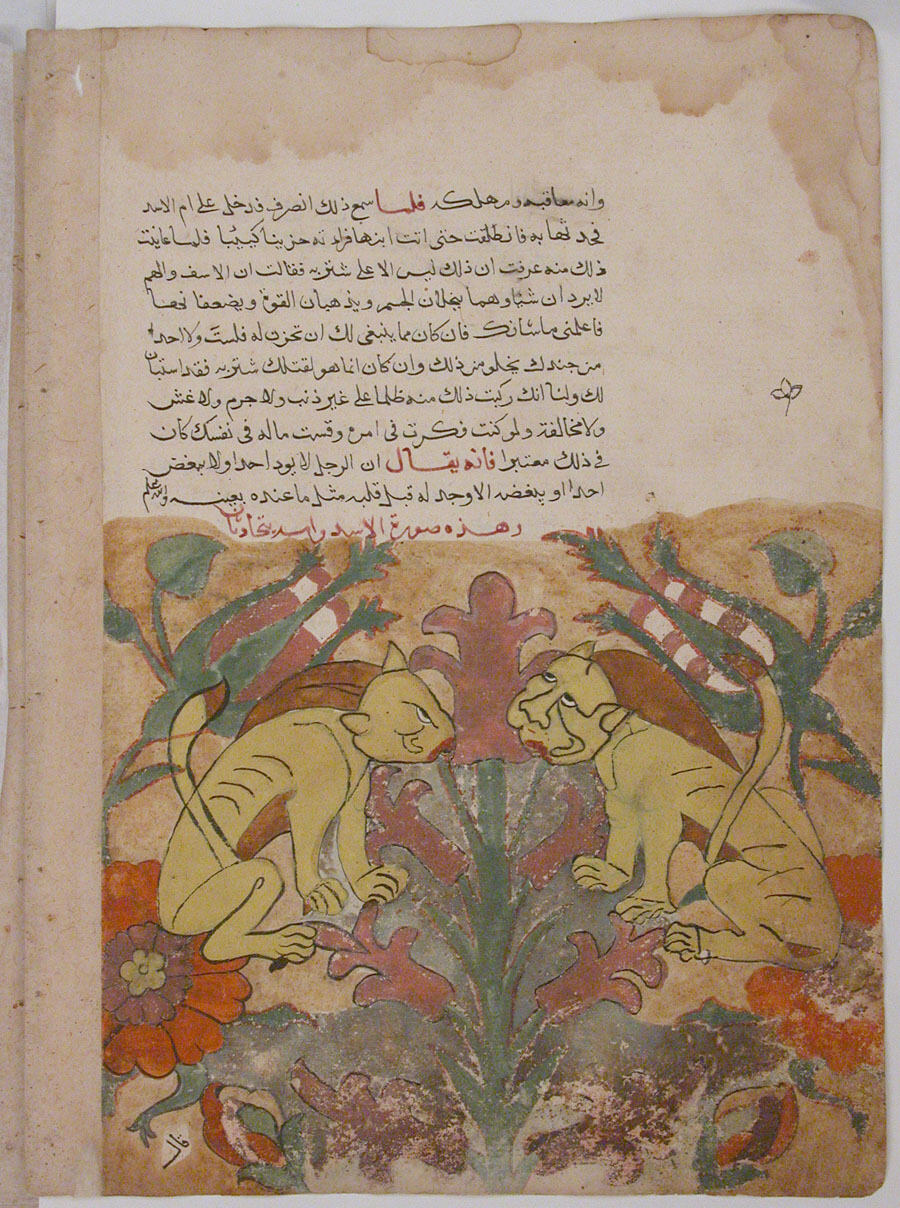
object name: folio from an illustrated manuscript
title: "The Lioness Counsels her Son", Folio from a Kalila wa Dimna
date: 1526-1550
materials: ink, paper, watercolor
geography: india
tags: lions